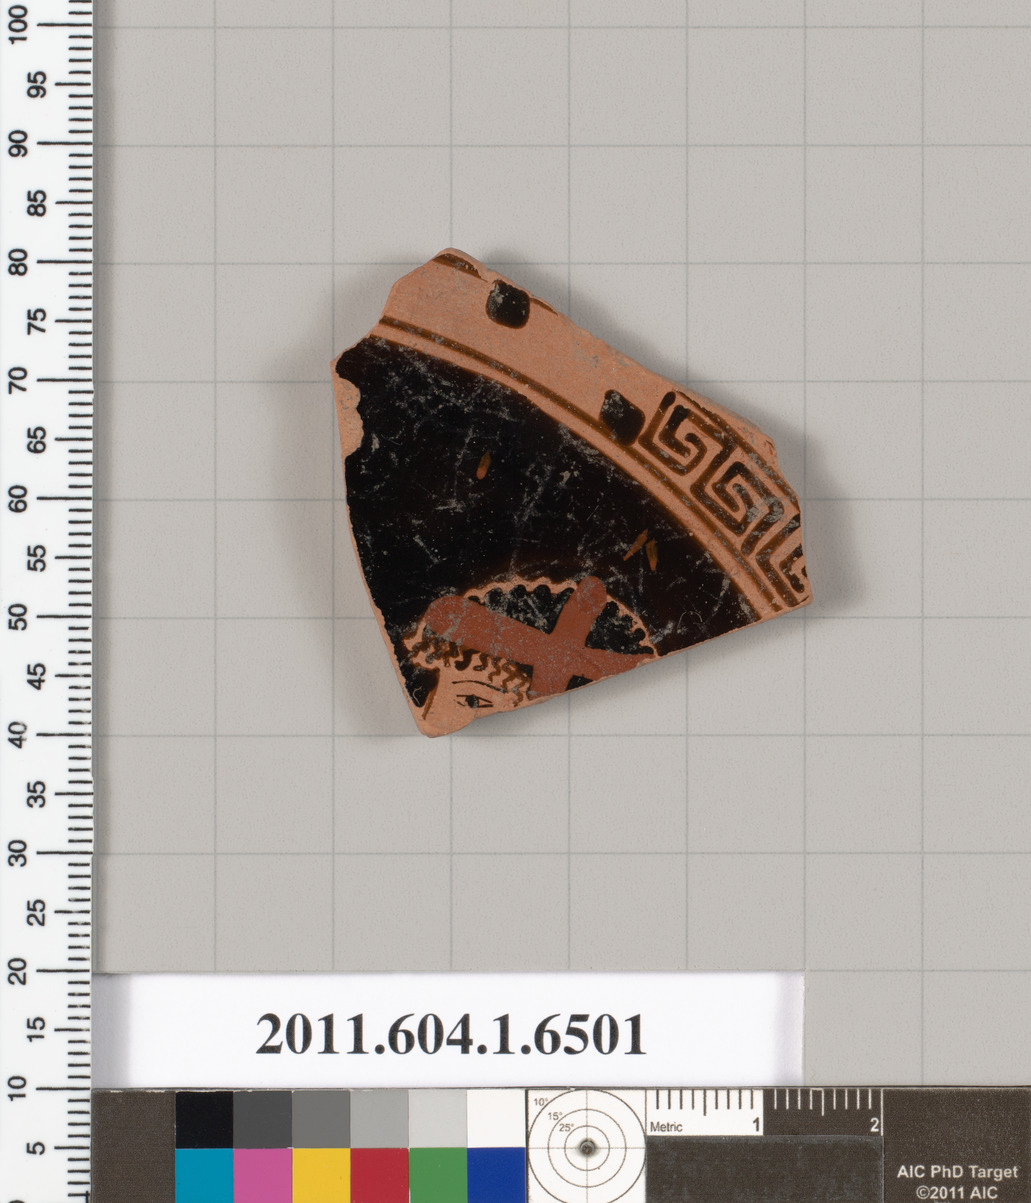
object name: kylix fragment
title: Terracotta fragment of a kylix (drinking cup)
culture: greek, attic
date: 490-480 BCE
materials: terracotta